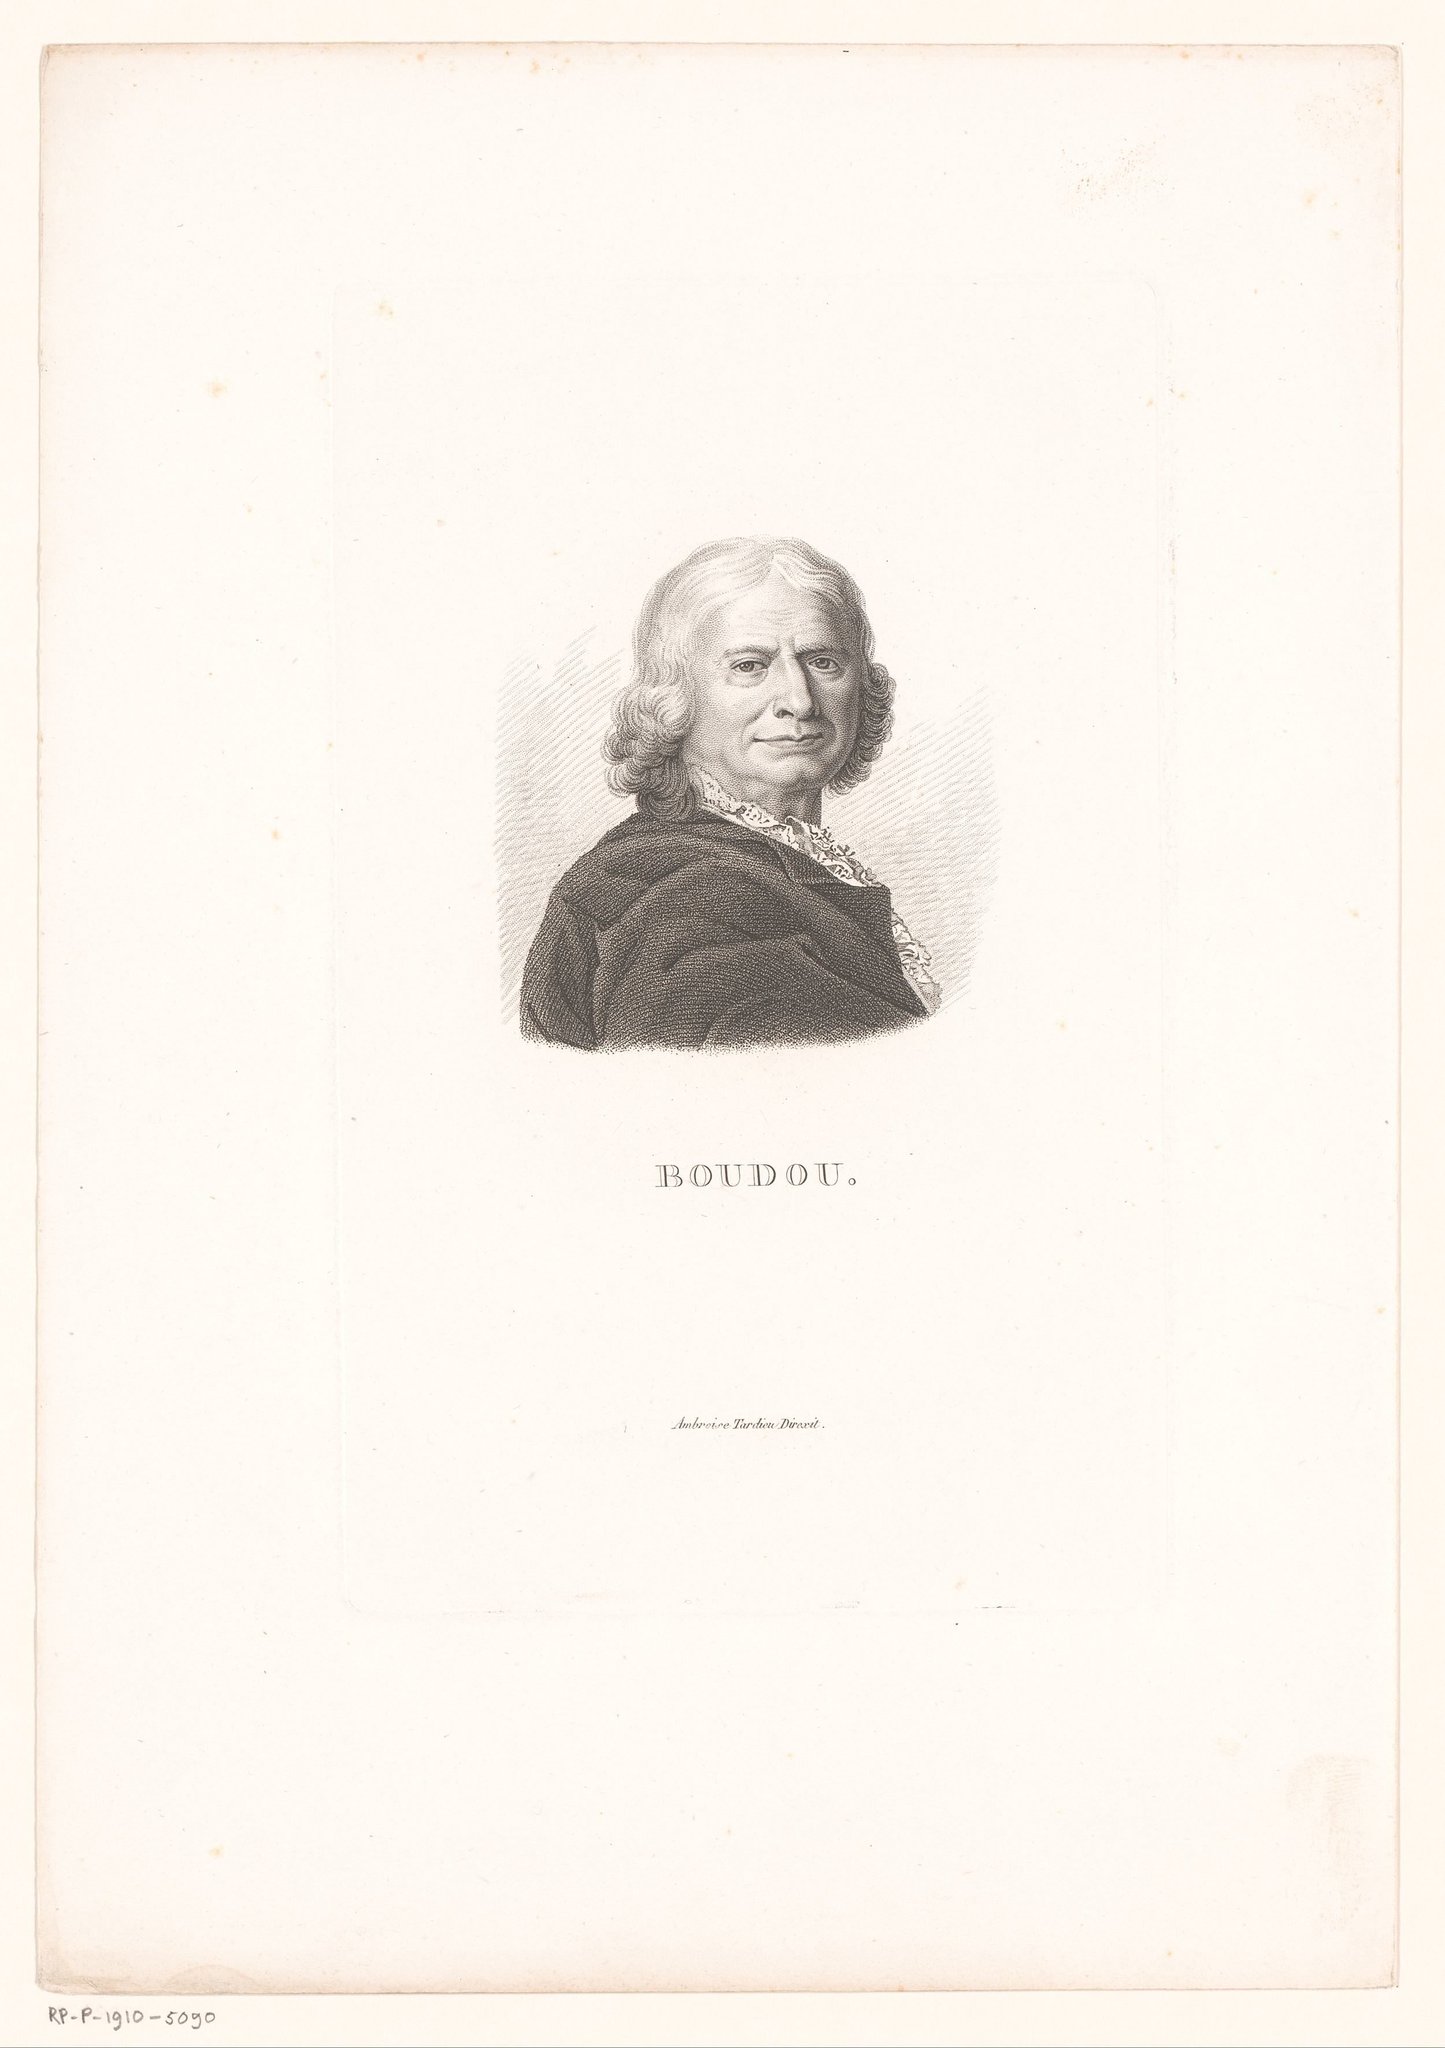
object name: print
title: Portret van Pierre Boudou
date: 1818-1832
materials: paper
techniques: engraving, etching, roulette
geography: paris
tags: historical persons, physician, doctor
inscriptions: collector's mark: Lugt 2228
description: Mogelijk prent uit: Journal complémentaire du Dictionnaire des sciences médicales. Parijs: Panckoucke, Charles Louis Fleury, 1818-1832.